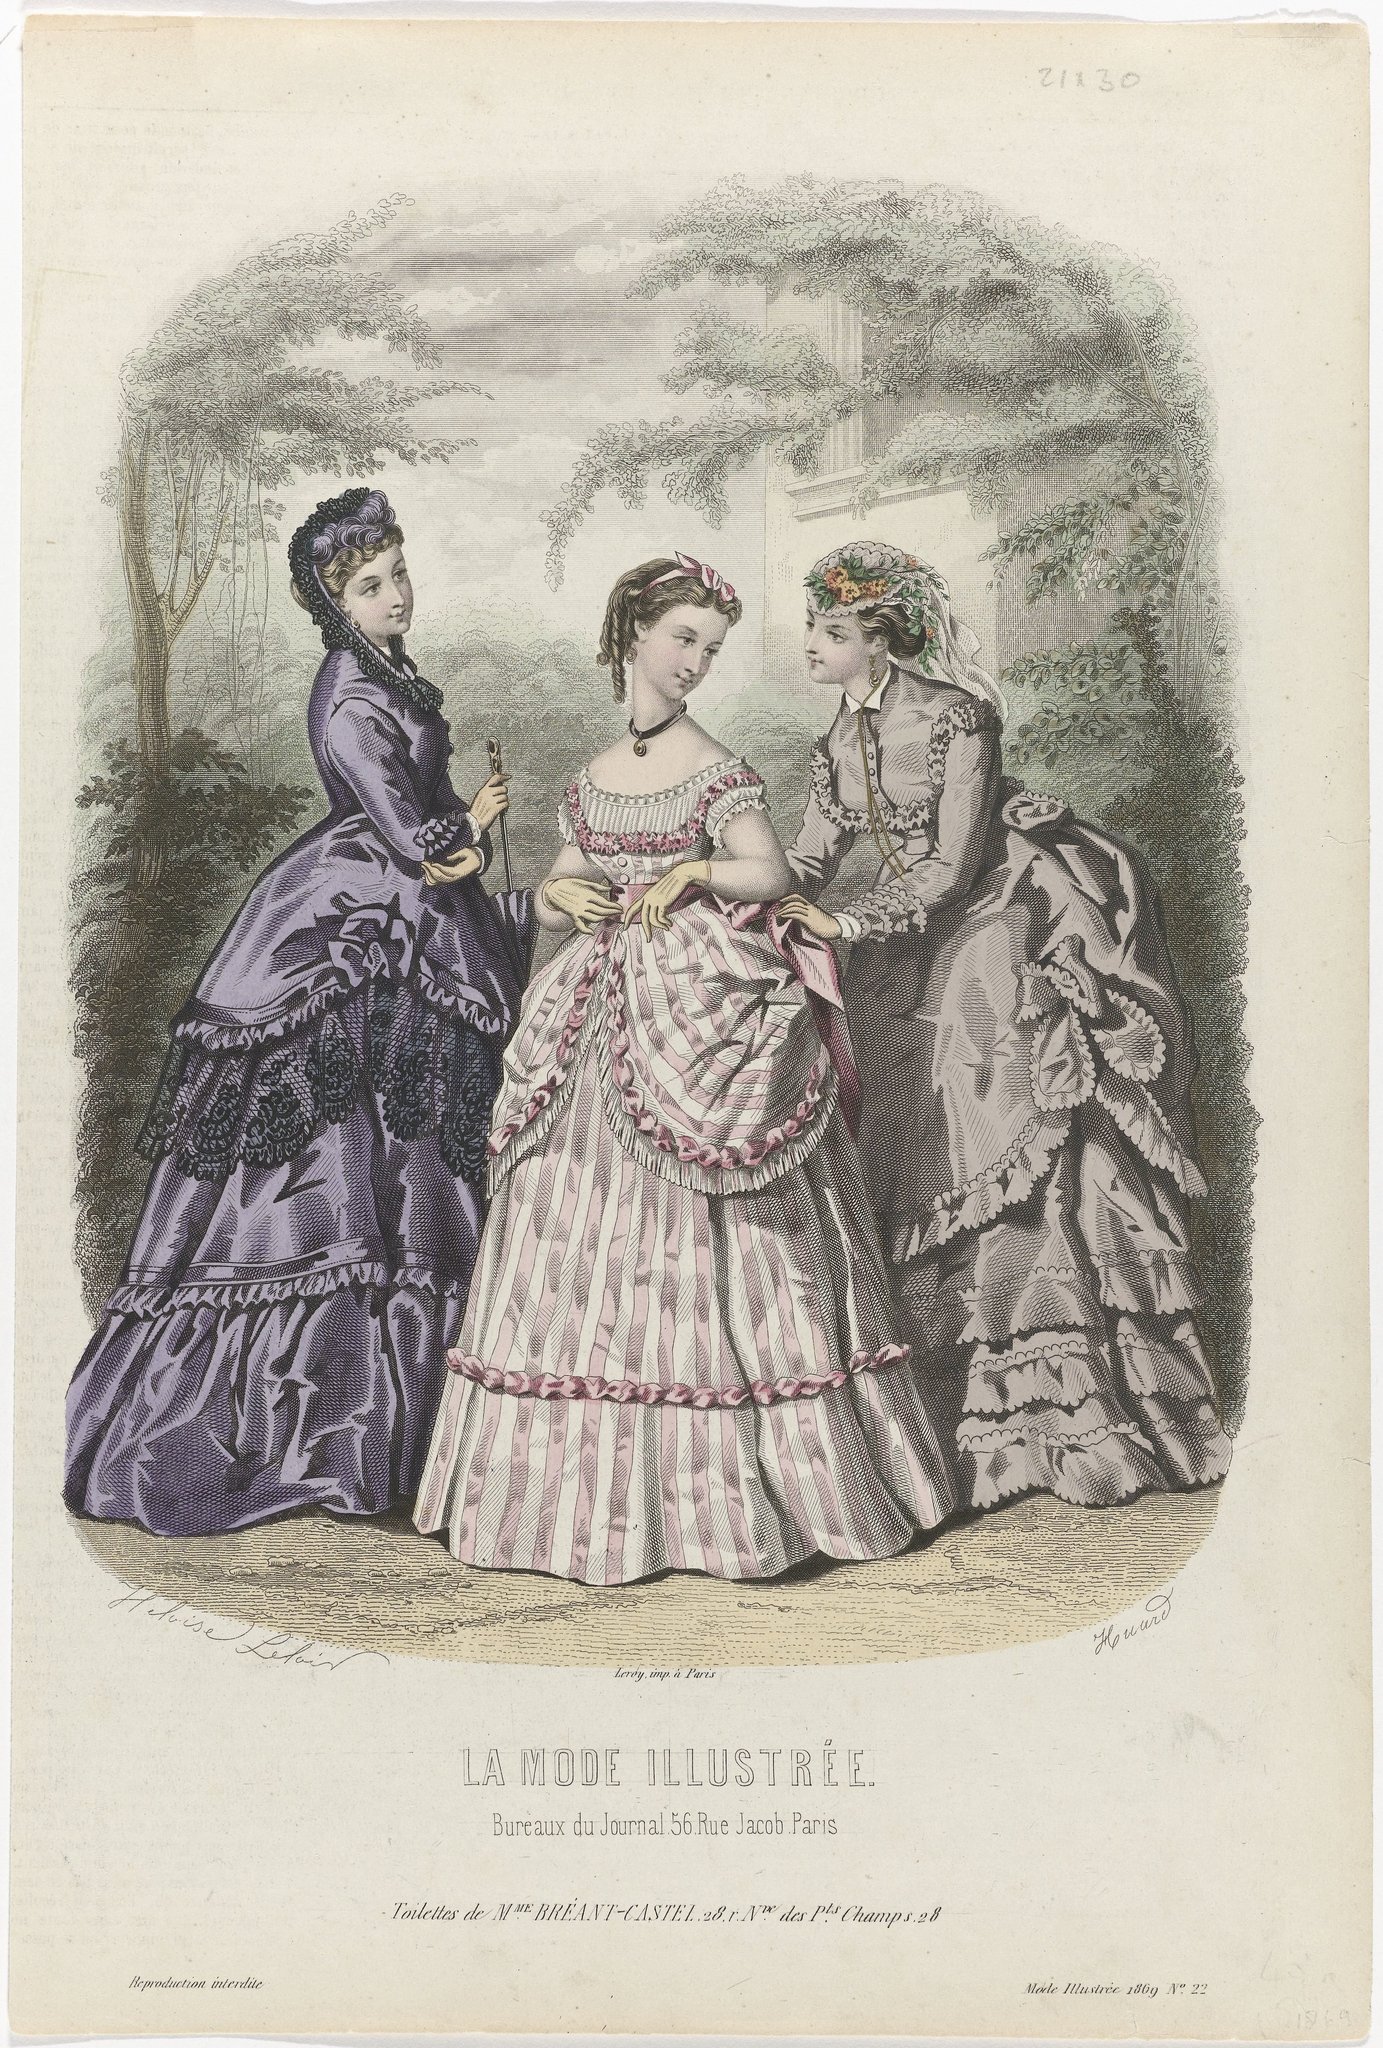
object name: fashion print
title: La Mode Illustrée, 1869, No. 22: Toilettes de Mme Breant Castel (...)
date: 1869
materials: paper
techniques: hand coloring, engraving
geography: paris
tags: ear-rings (+ women's clothes), pendant, trinket, 'breloque' (+ women's clothes), dressing someone else - aa - female human figure, fashion plates, head-gear: hat (+ women's clothes), gloves, mittens, etc. (+ women's clothes), dress, gown (+ women's clothes), necklace (+ women's clothes), belt, girdle, waistband (+ women's clothes)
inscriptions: title: ‘La Mode Illustrée’, address: ‘Bureaux du Journal, 56, Rue Jacob. Paris’, caption: ‘Toilettes de M.me Bréant-Castel. 28.r. N.ve des P.ts Champs. 28’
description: Drie vrouwen in de buitenlucht, één van hen corrigeert de japon van de ander. Volgens het onderschrift: ensembles van Bréant-Castel. Prent uit het modetijdschrift La Mode Illustrée (1860-1937).